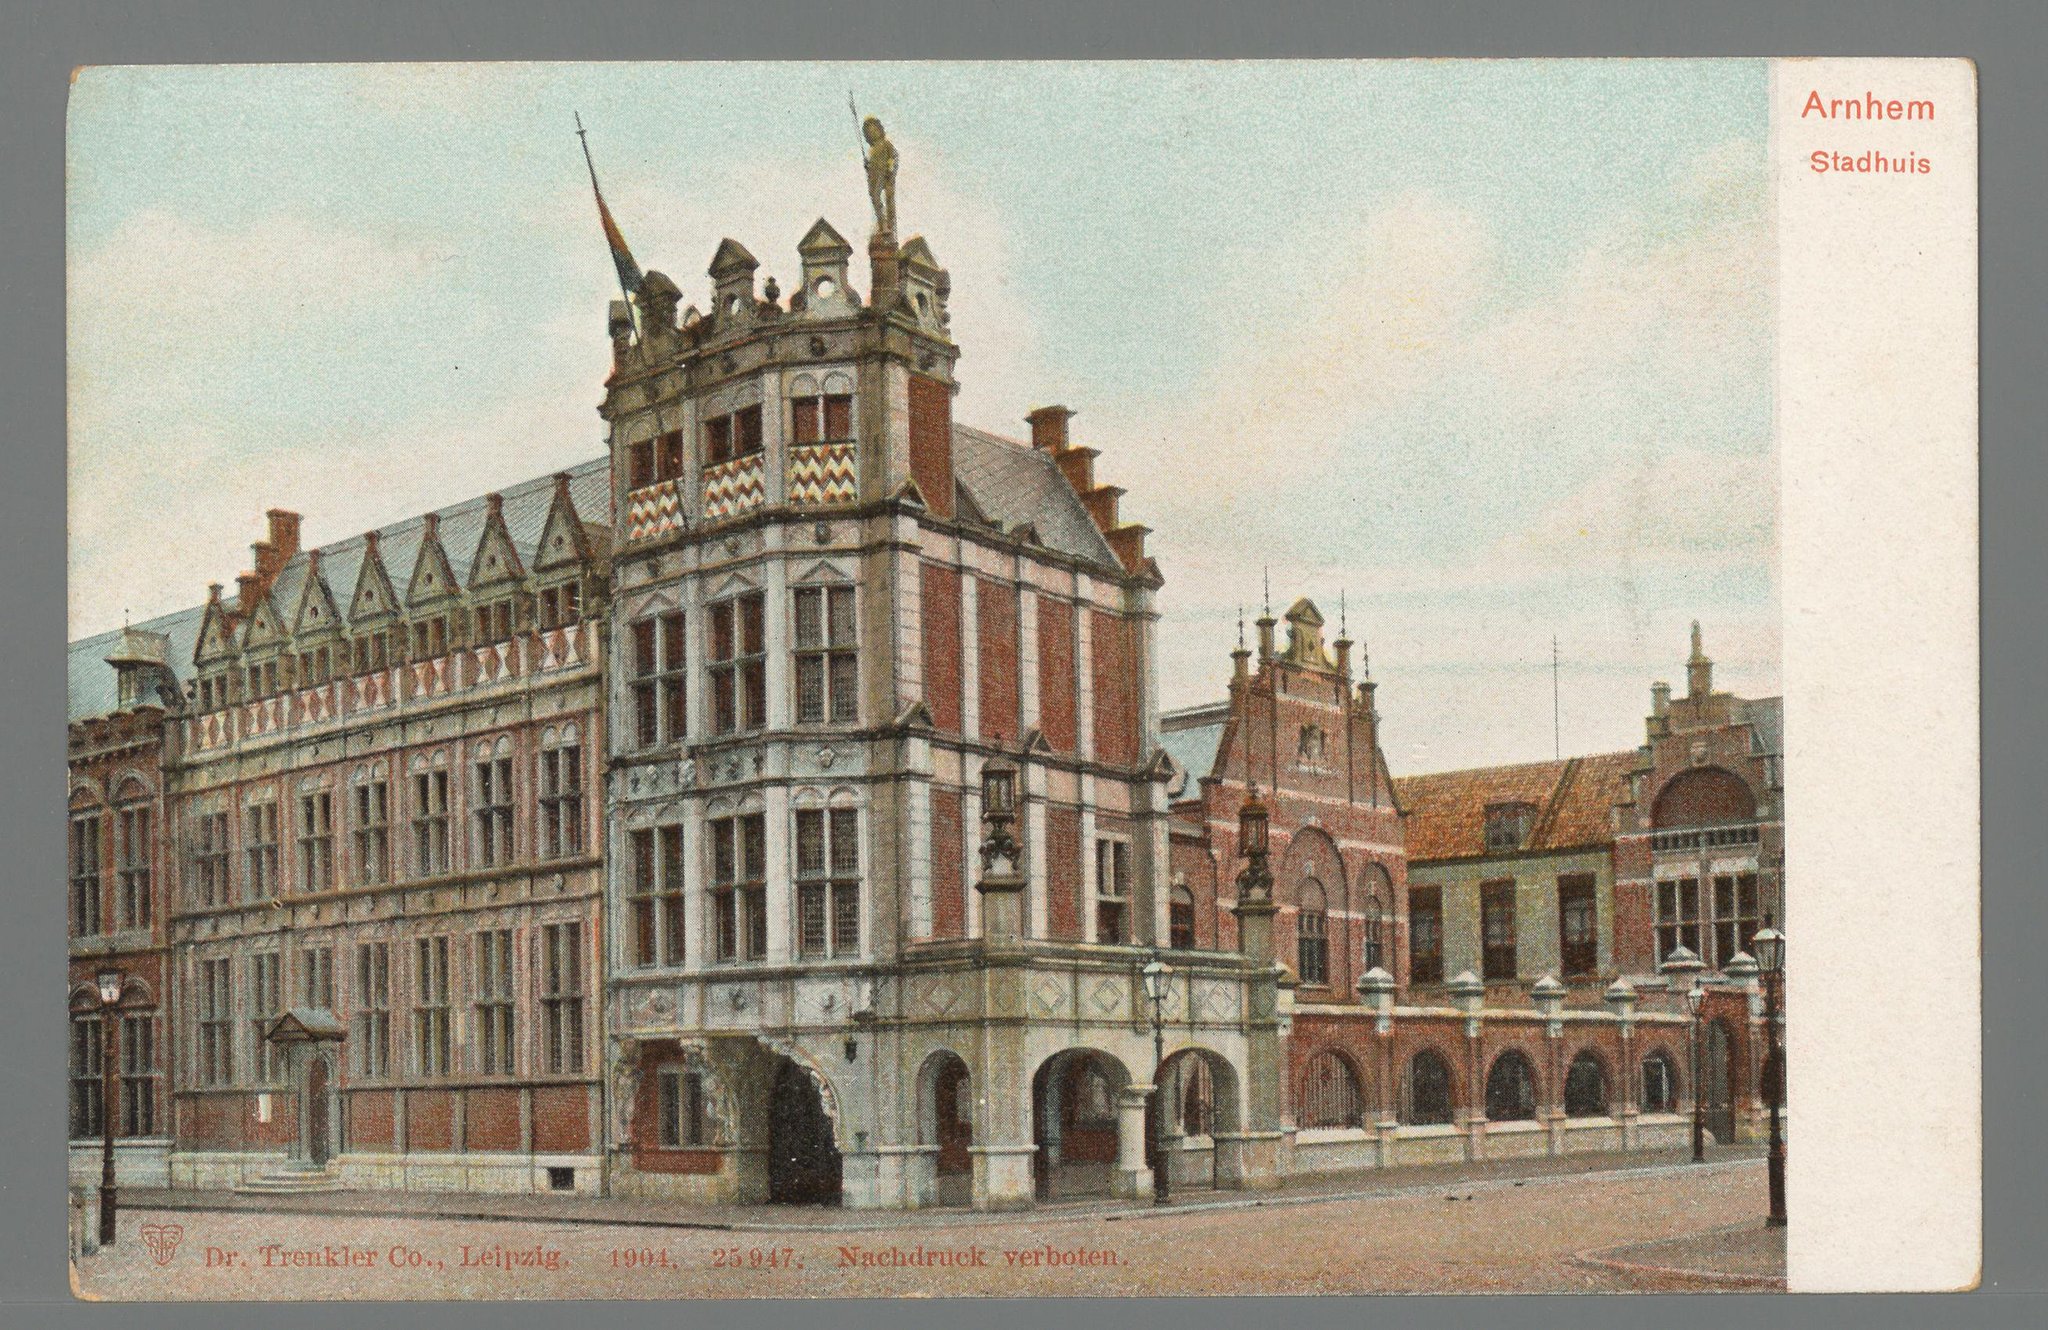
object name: ansichtkaart, prentbriefkaart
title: Arnhem. Stadhuis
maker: Anonymous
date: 1904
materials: cardboard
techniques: lithograph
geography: leipzig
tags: townhall, street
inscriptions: date